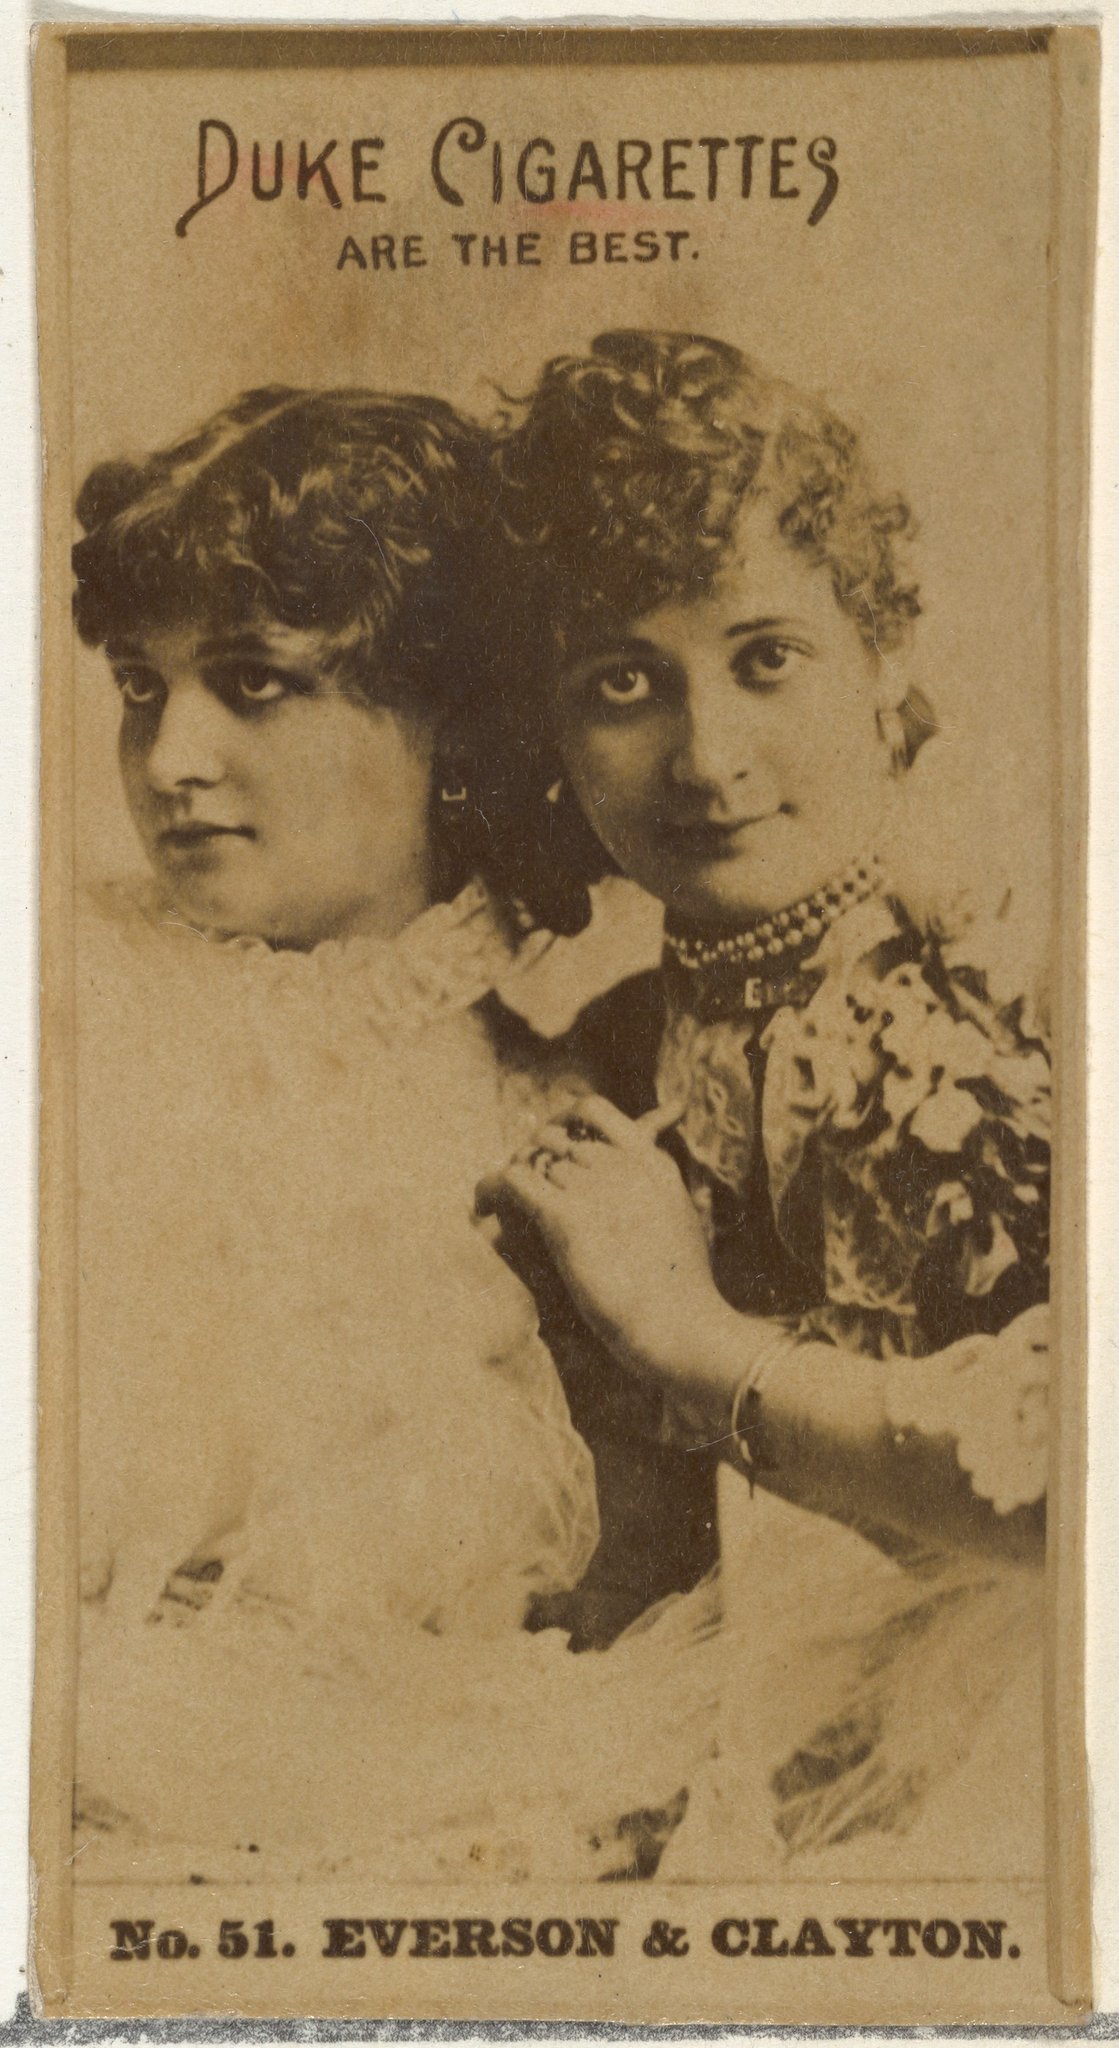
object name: photograph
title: Card Number 51, Everson & Clayton, from the Actors and Actresses series (N145-6) issued by Duke Sons & Co. to promote Duke Cigarettes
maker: w. duke, sons & co.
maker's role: publisher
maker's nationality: american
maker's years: 1870-1920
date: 1880-1889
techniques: albumen silver print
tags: portraits,women,actresses